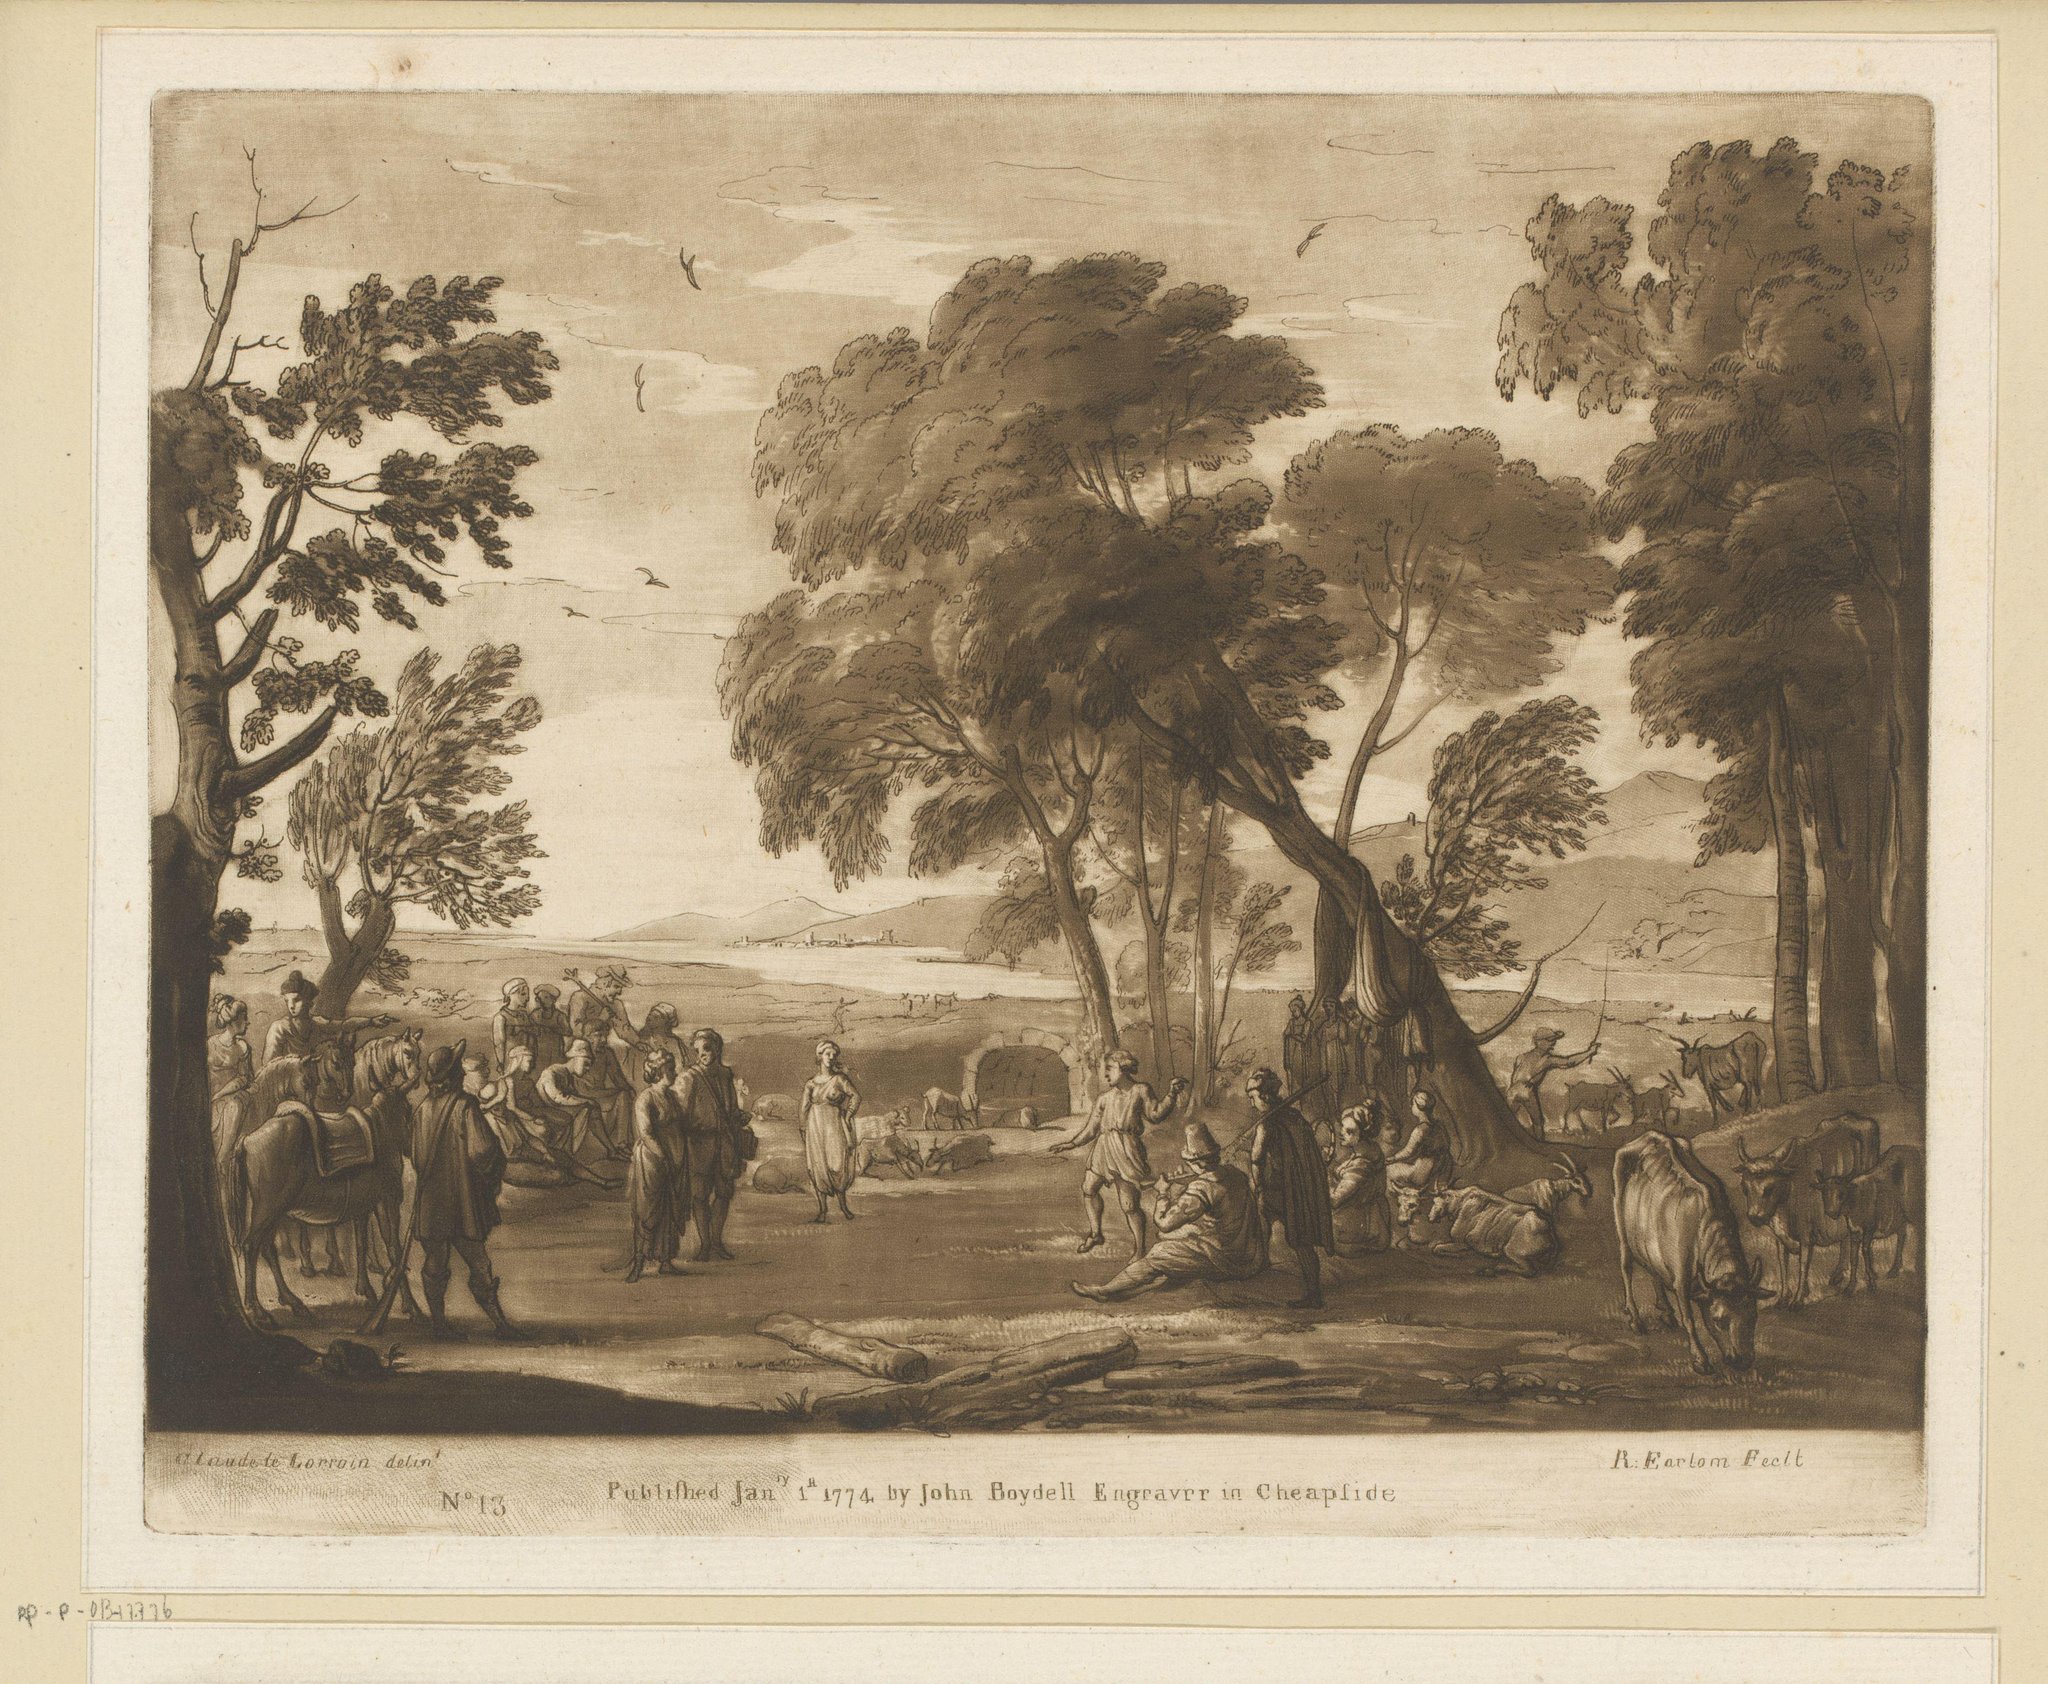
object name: print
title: Prenten naar tekeningen van Claude Lorrain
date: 1774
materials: paper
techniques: etching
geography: london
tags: dancing, cattle, making music; musician with instrument - cc - out of doors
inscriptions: date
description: Vanaf 1774 publiceerde John Boydell tweehonderd prenten naar het tekeningenboek Liber Veritatis van Claude Lorrain, in het bezit van de hertogen van Cavendish. Deze werden vanaf 1777 in twee volumes gebundeld uitgegeven.